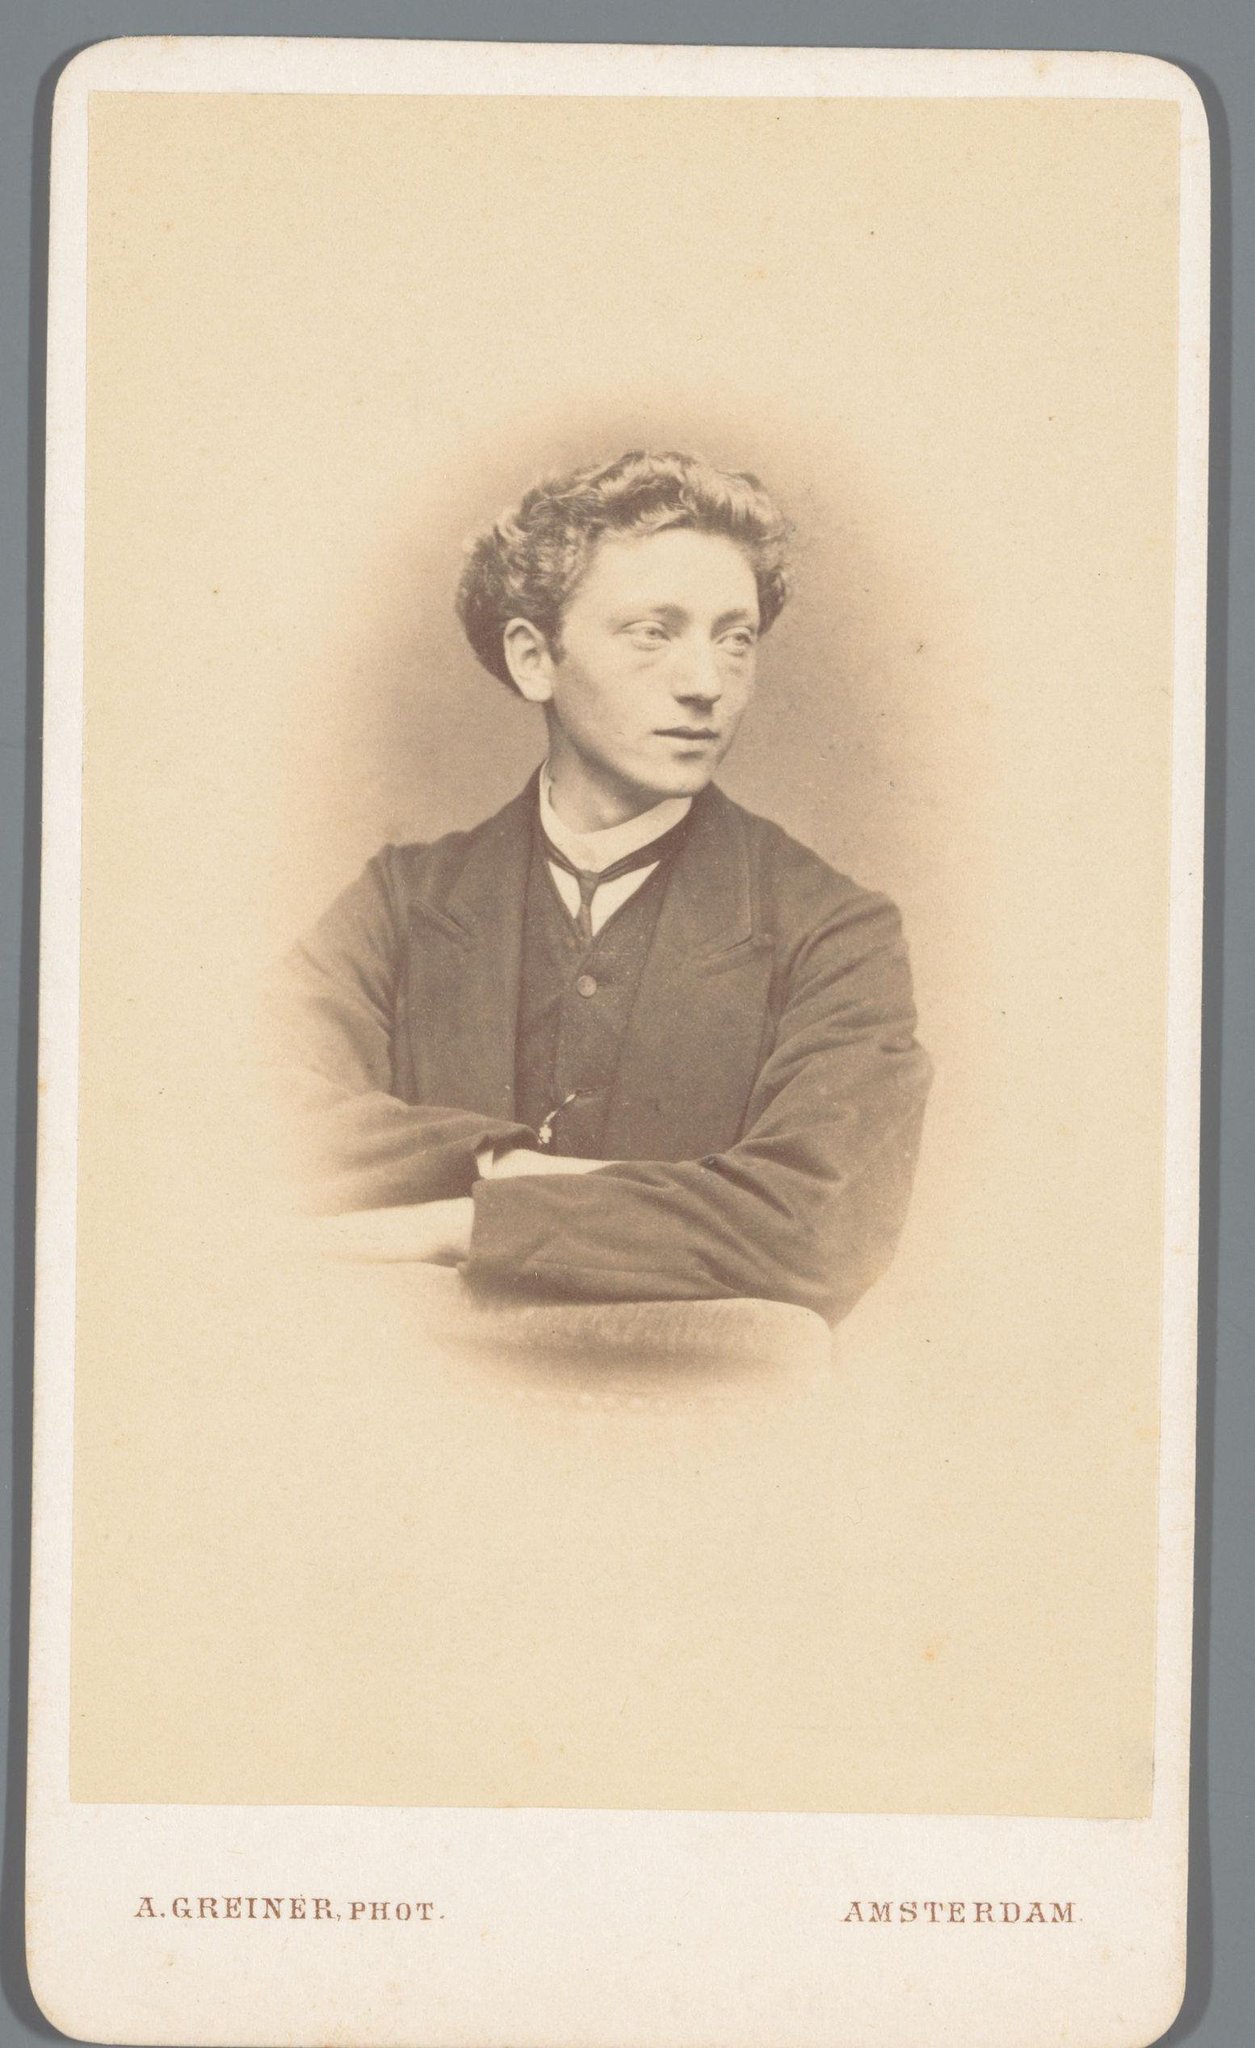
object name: carte de visite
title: Portret van een onbekende man met zijn armen over elkaar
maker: albert greiner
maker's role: fotograaf, fotostudio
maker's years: 1833-1890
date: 1861-1874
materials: cardboard, paper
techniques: albumen print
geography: amsterdam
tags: arms folded over the abdomen, historical persons, youth, adolescent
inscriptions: inscription: ‘AG/ A. GREINER/ Photograf/ NIEUWENDIJK L. 87/ AMSTERDAM.’